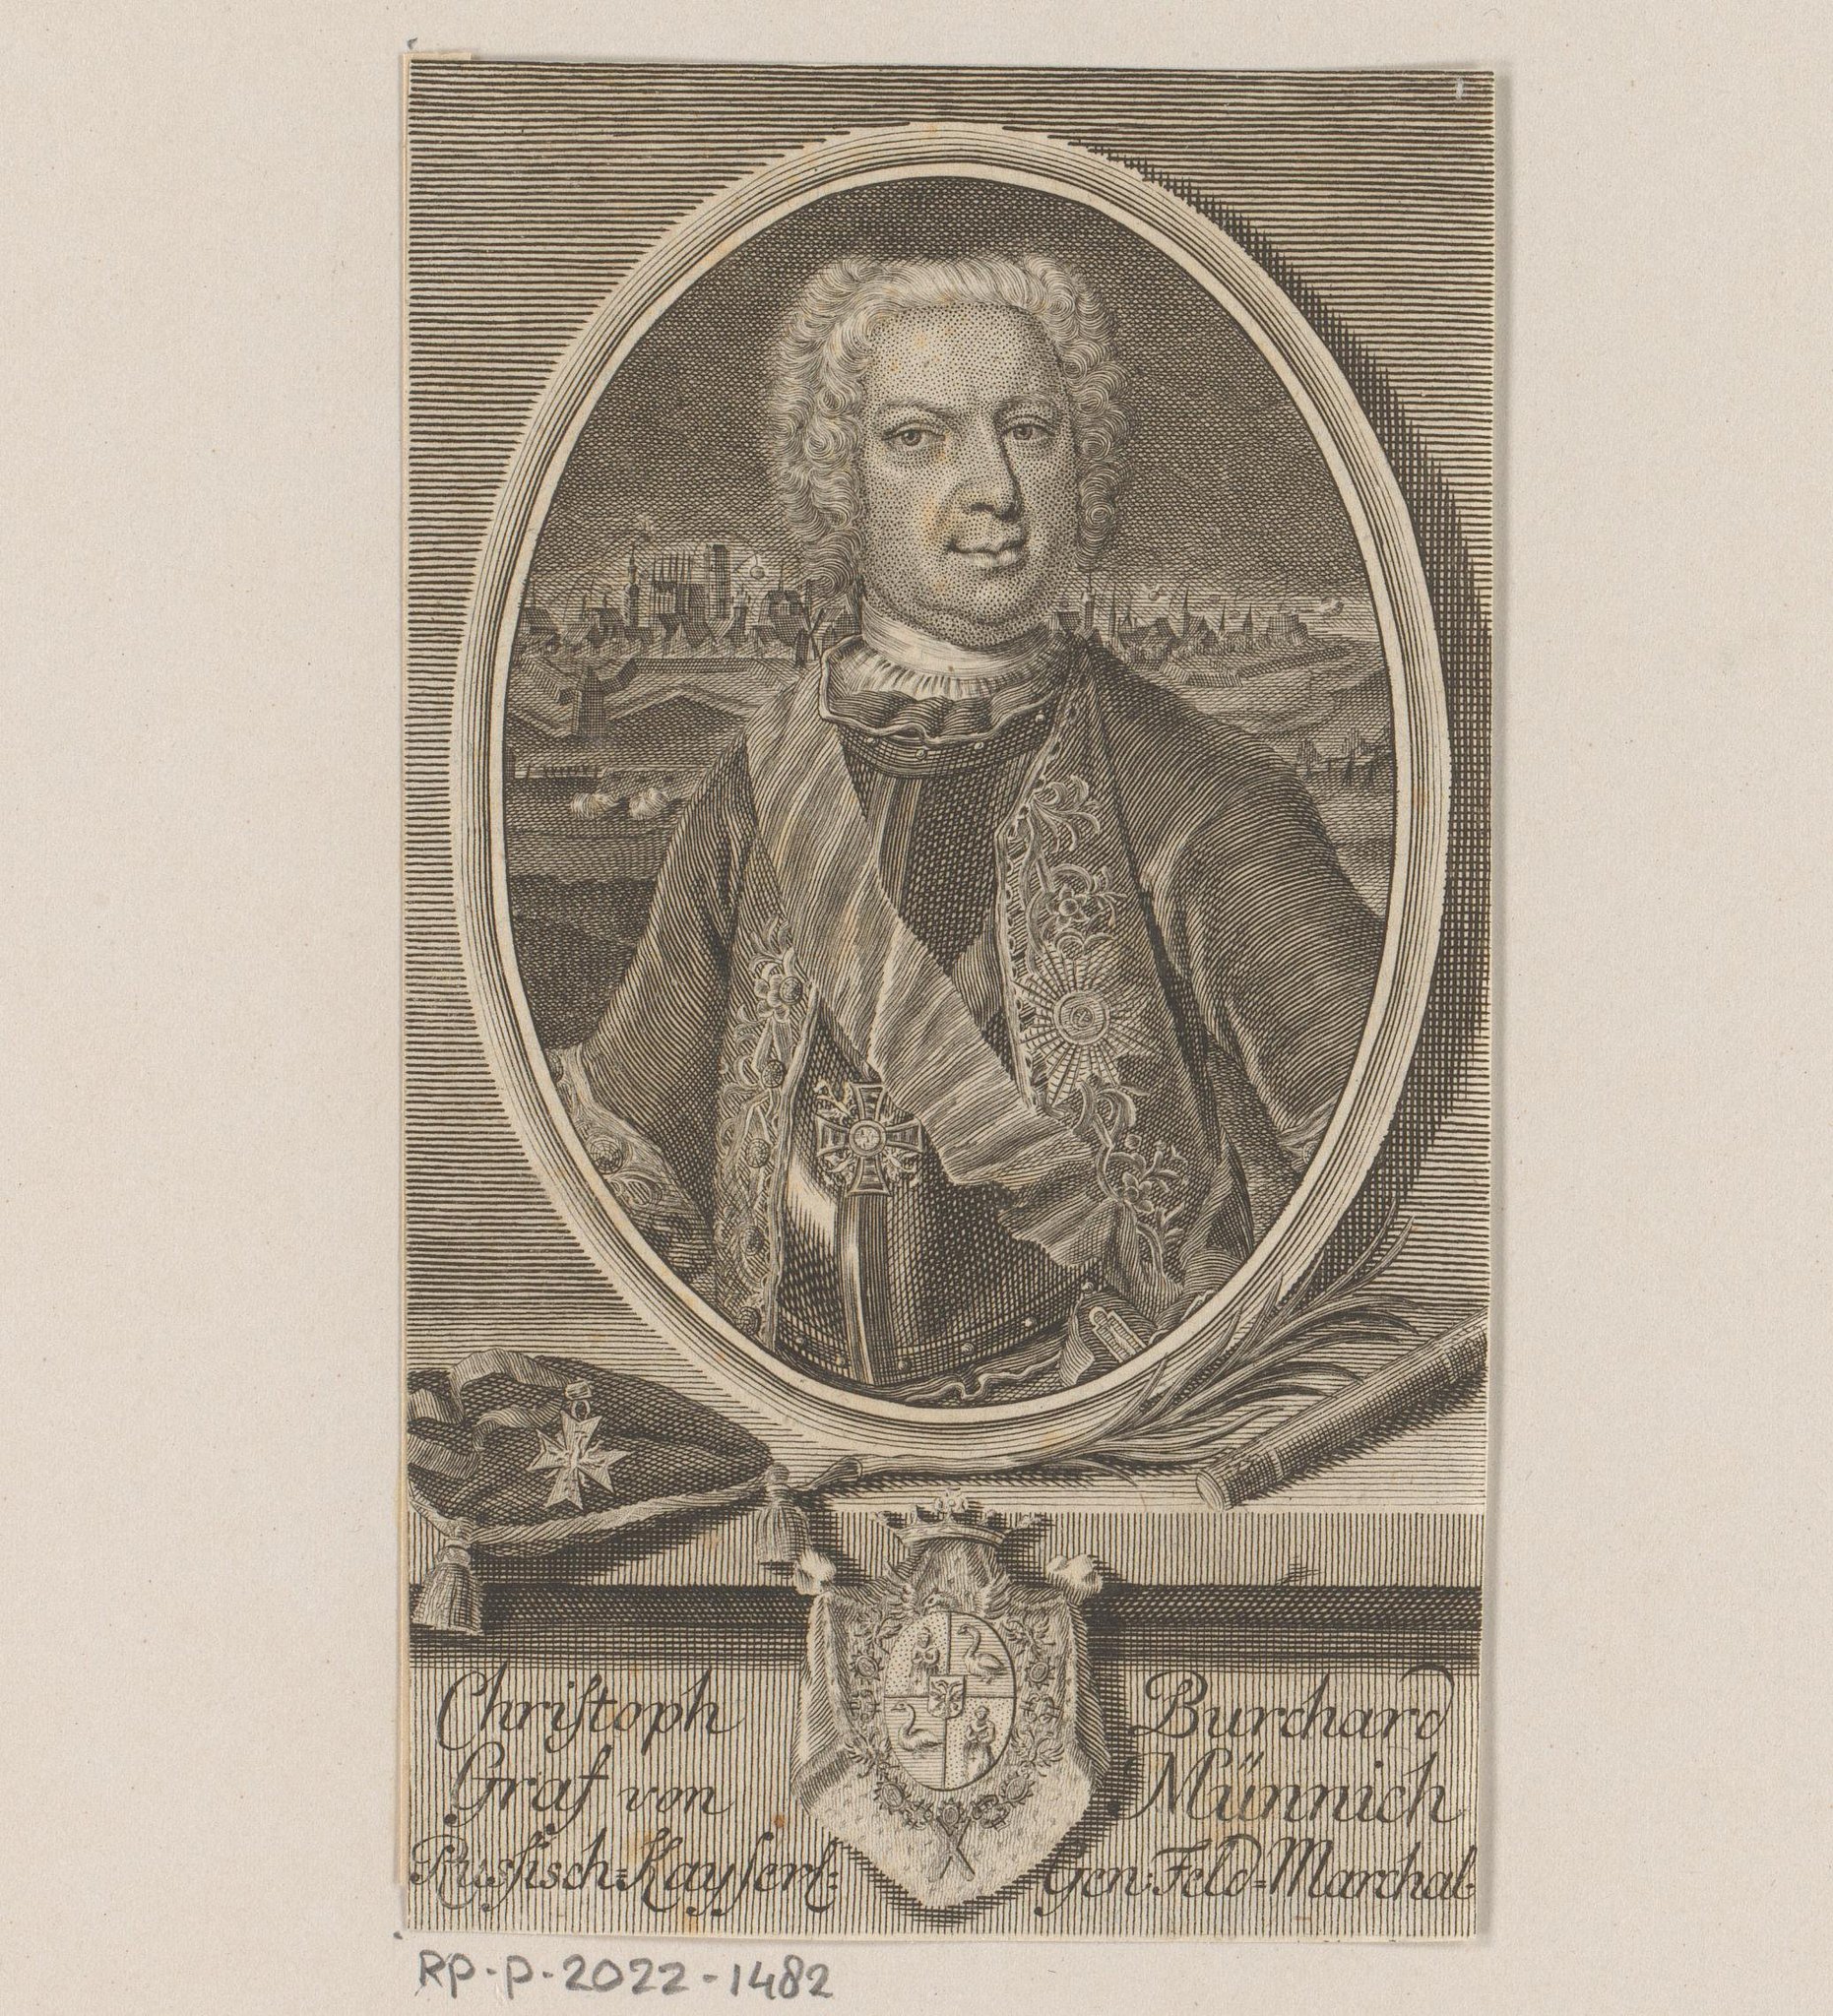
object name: print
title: Christoph Burchard Graf von Münnich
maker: johann martin bernigeroth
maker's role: print maker, publisher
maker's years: 1713-1767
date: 1723-1767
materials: paper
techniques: engraving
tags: armour, historical persons